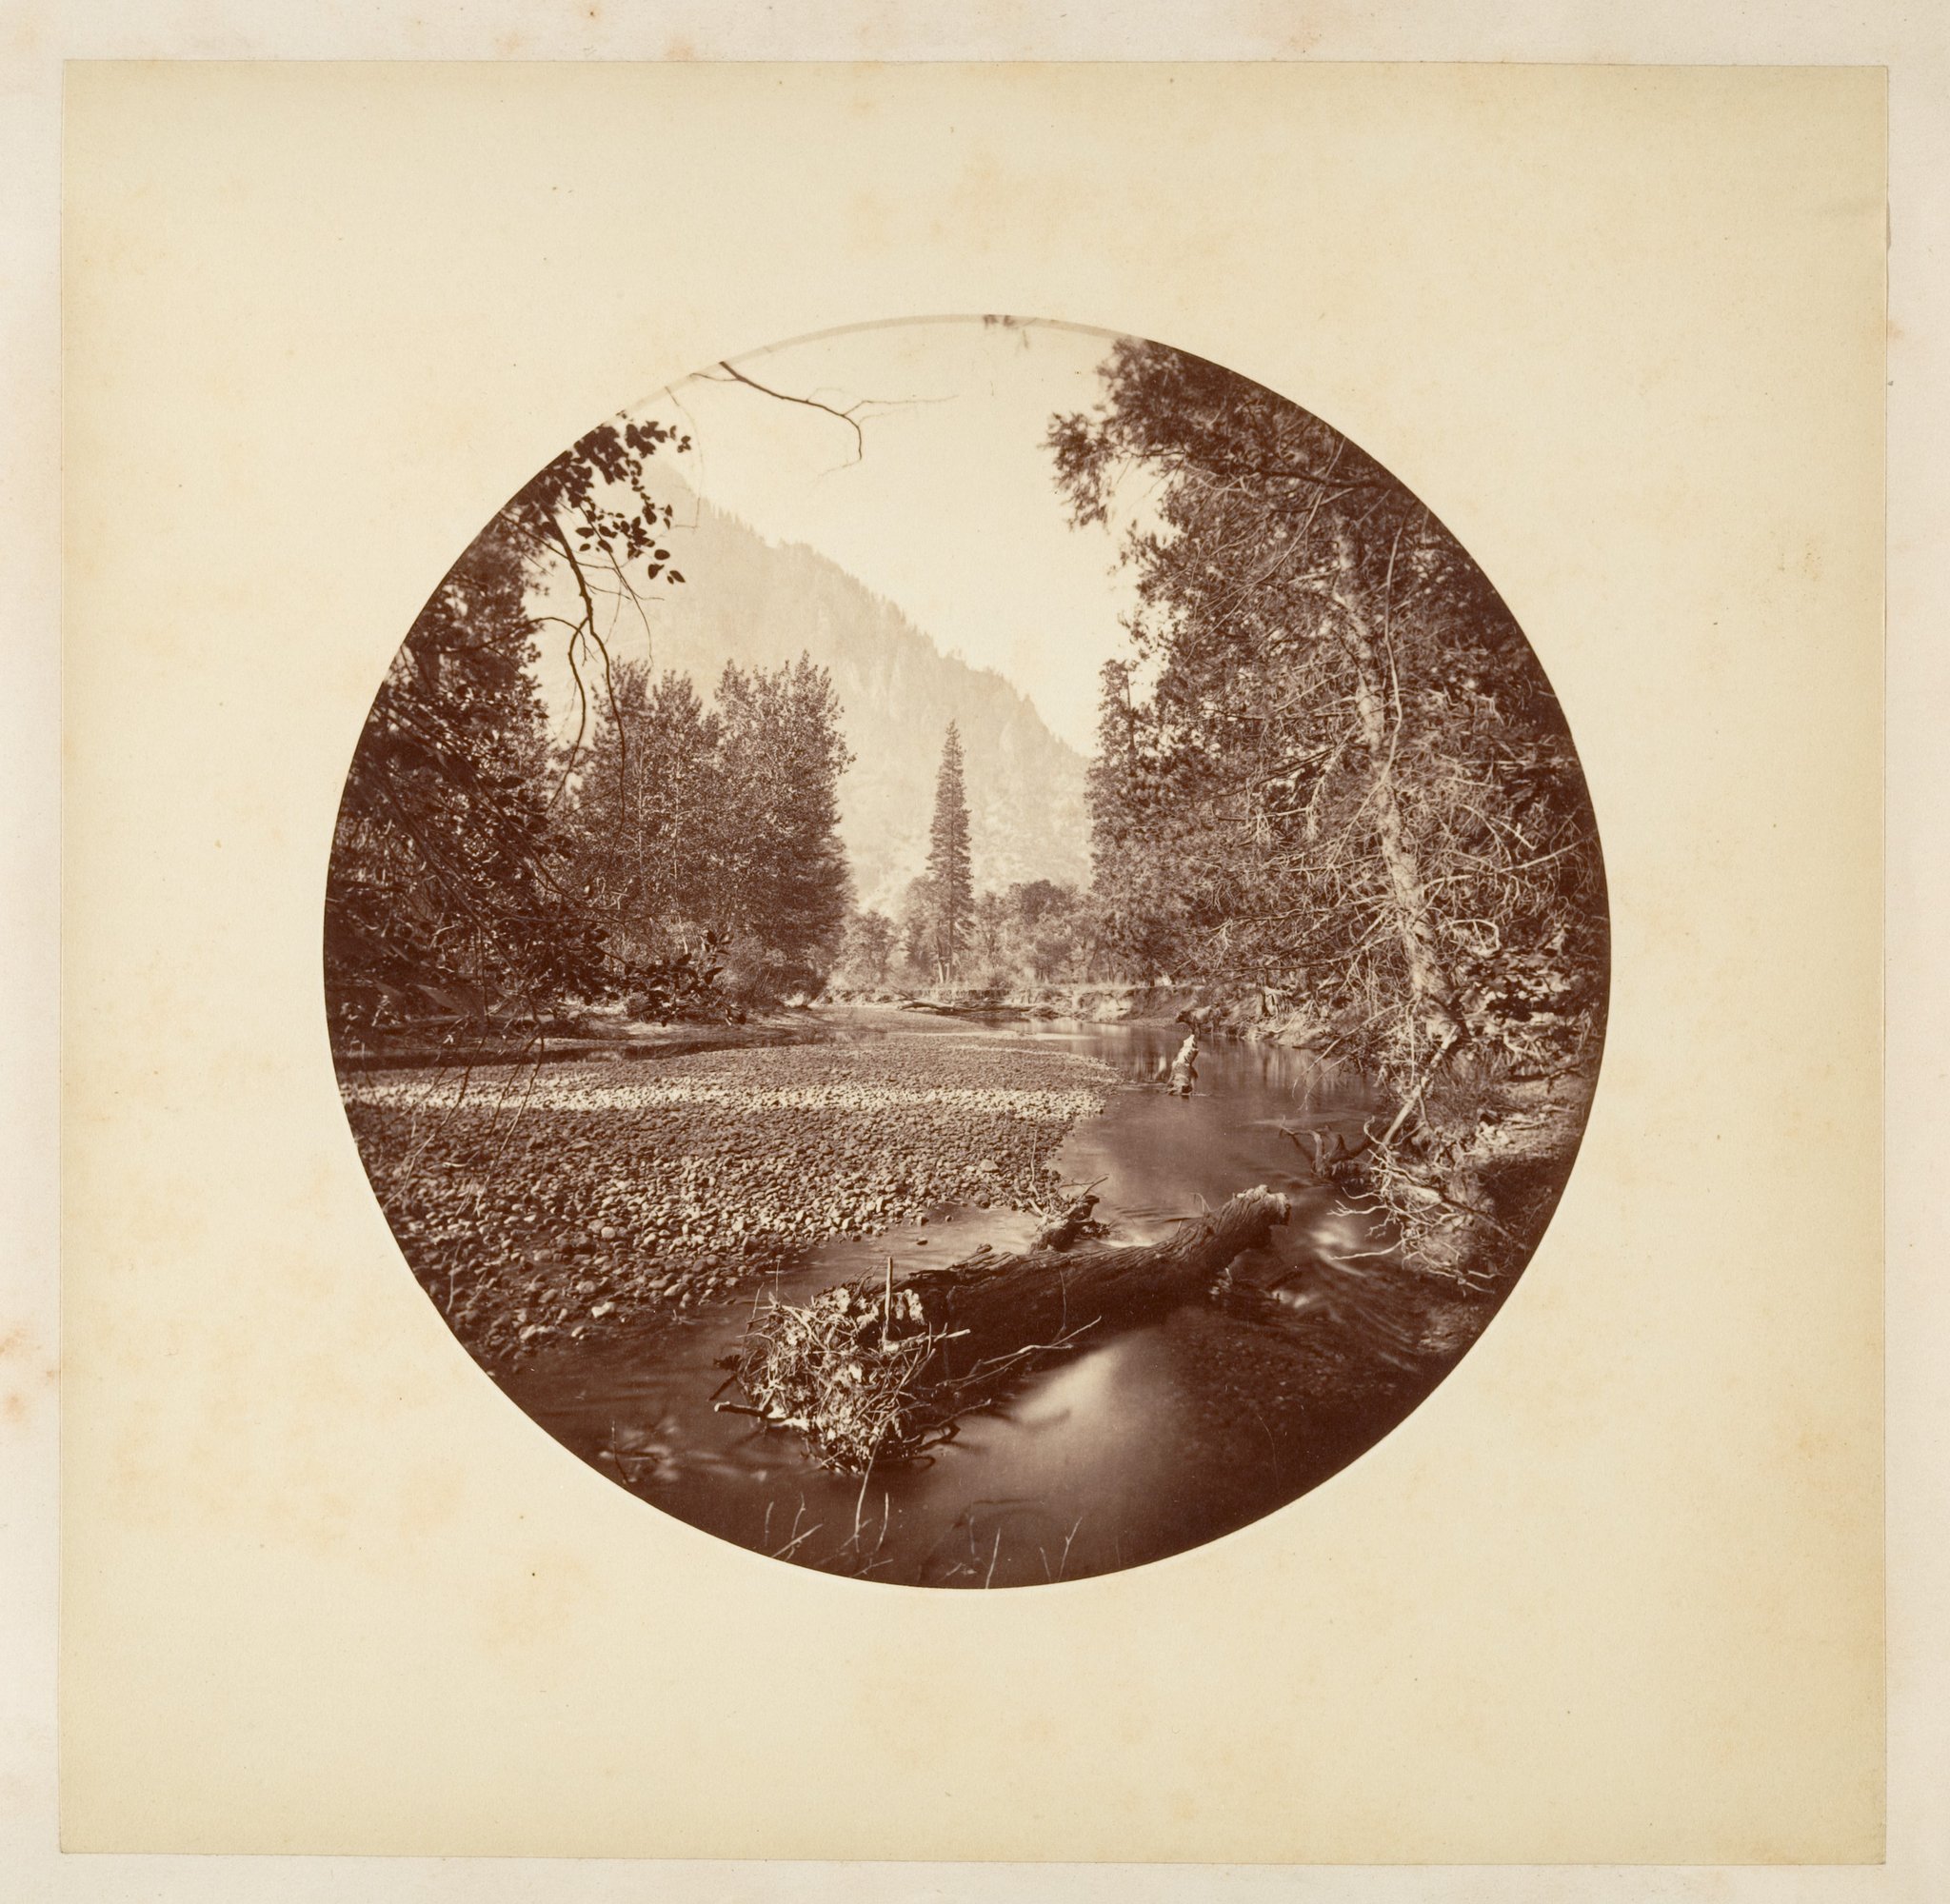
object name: photograph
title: [Yosemite National Park, California]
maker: carleton e. watkins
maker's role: artist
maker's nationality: american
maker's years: 1829-1916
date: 1878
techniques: albumen silver print, glass negative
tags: rivers,landscapes